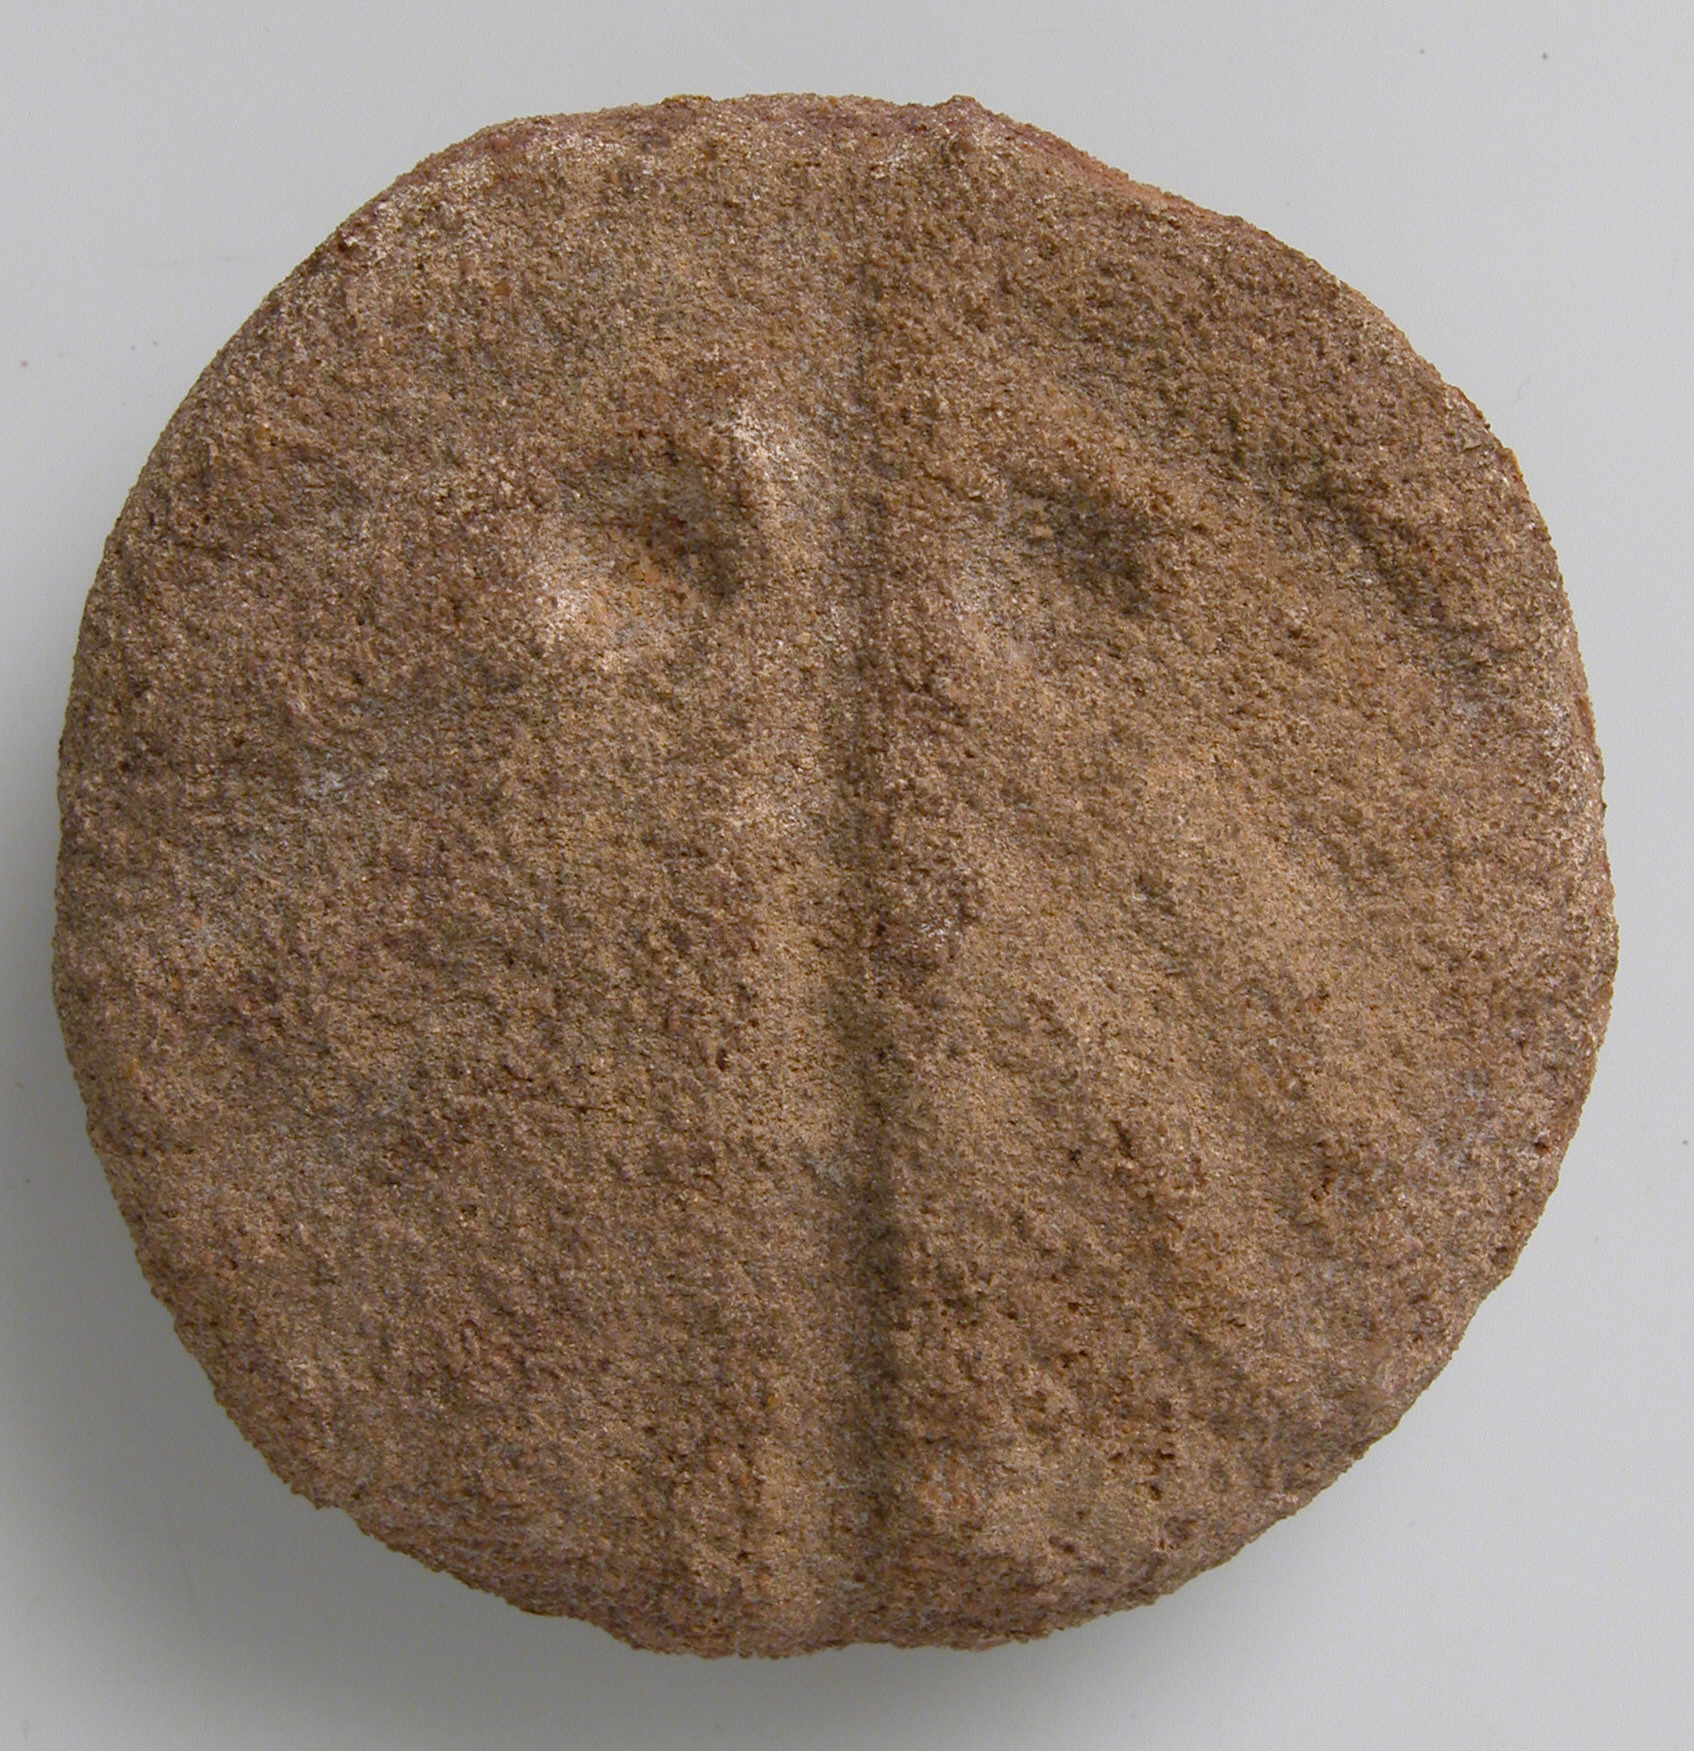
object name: stone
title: Stone Roundel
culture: coptic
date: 301-700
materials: stone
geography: egypt